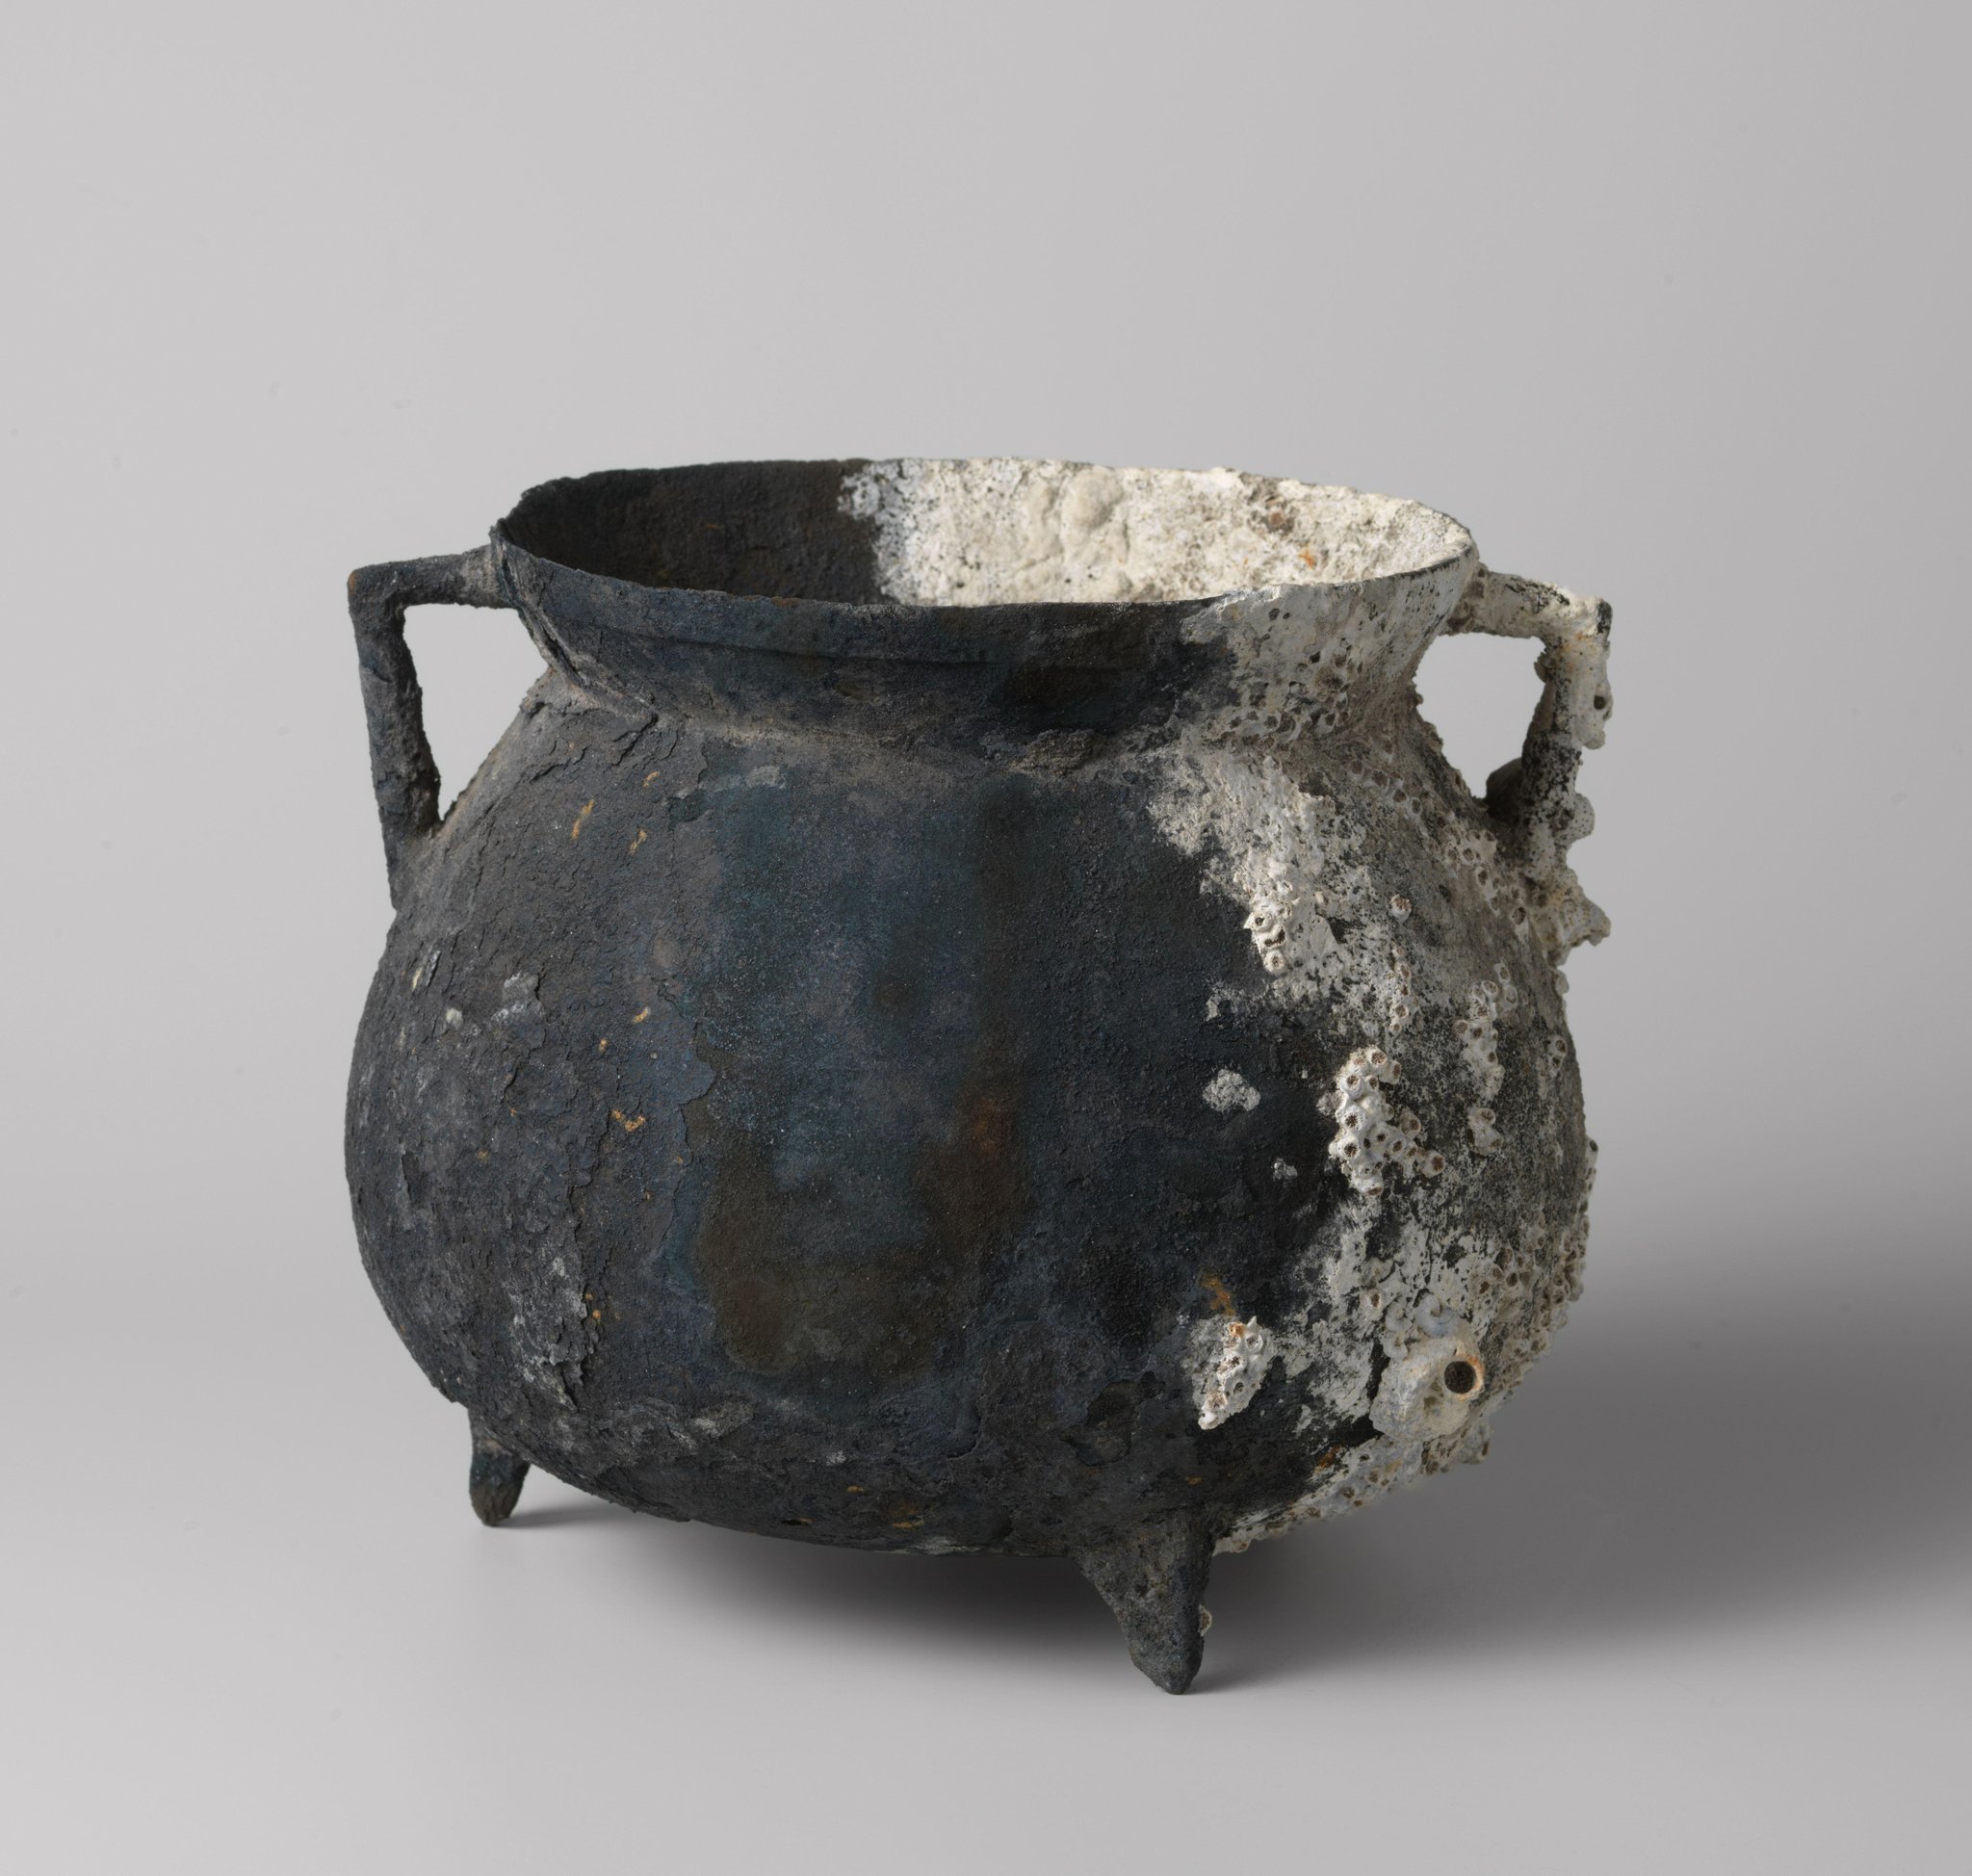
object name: cauldron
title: Kookpot of grape op pootjes uit V.O.C.-schip de 'Witte Leeuw'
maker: Anonymous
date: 1613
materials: iron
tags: verenigde oostindische compagnie, sint-helena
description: Gietijzeren kookpot van het grapetype, oorspronkelijk op drie pootjes waarvan er nu twee resteren, afkomstig uit het wrak van het V.O.C.-schip de 'Witte Leeuw'.